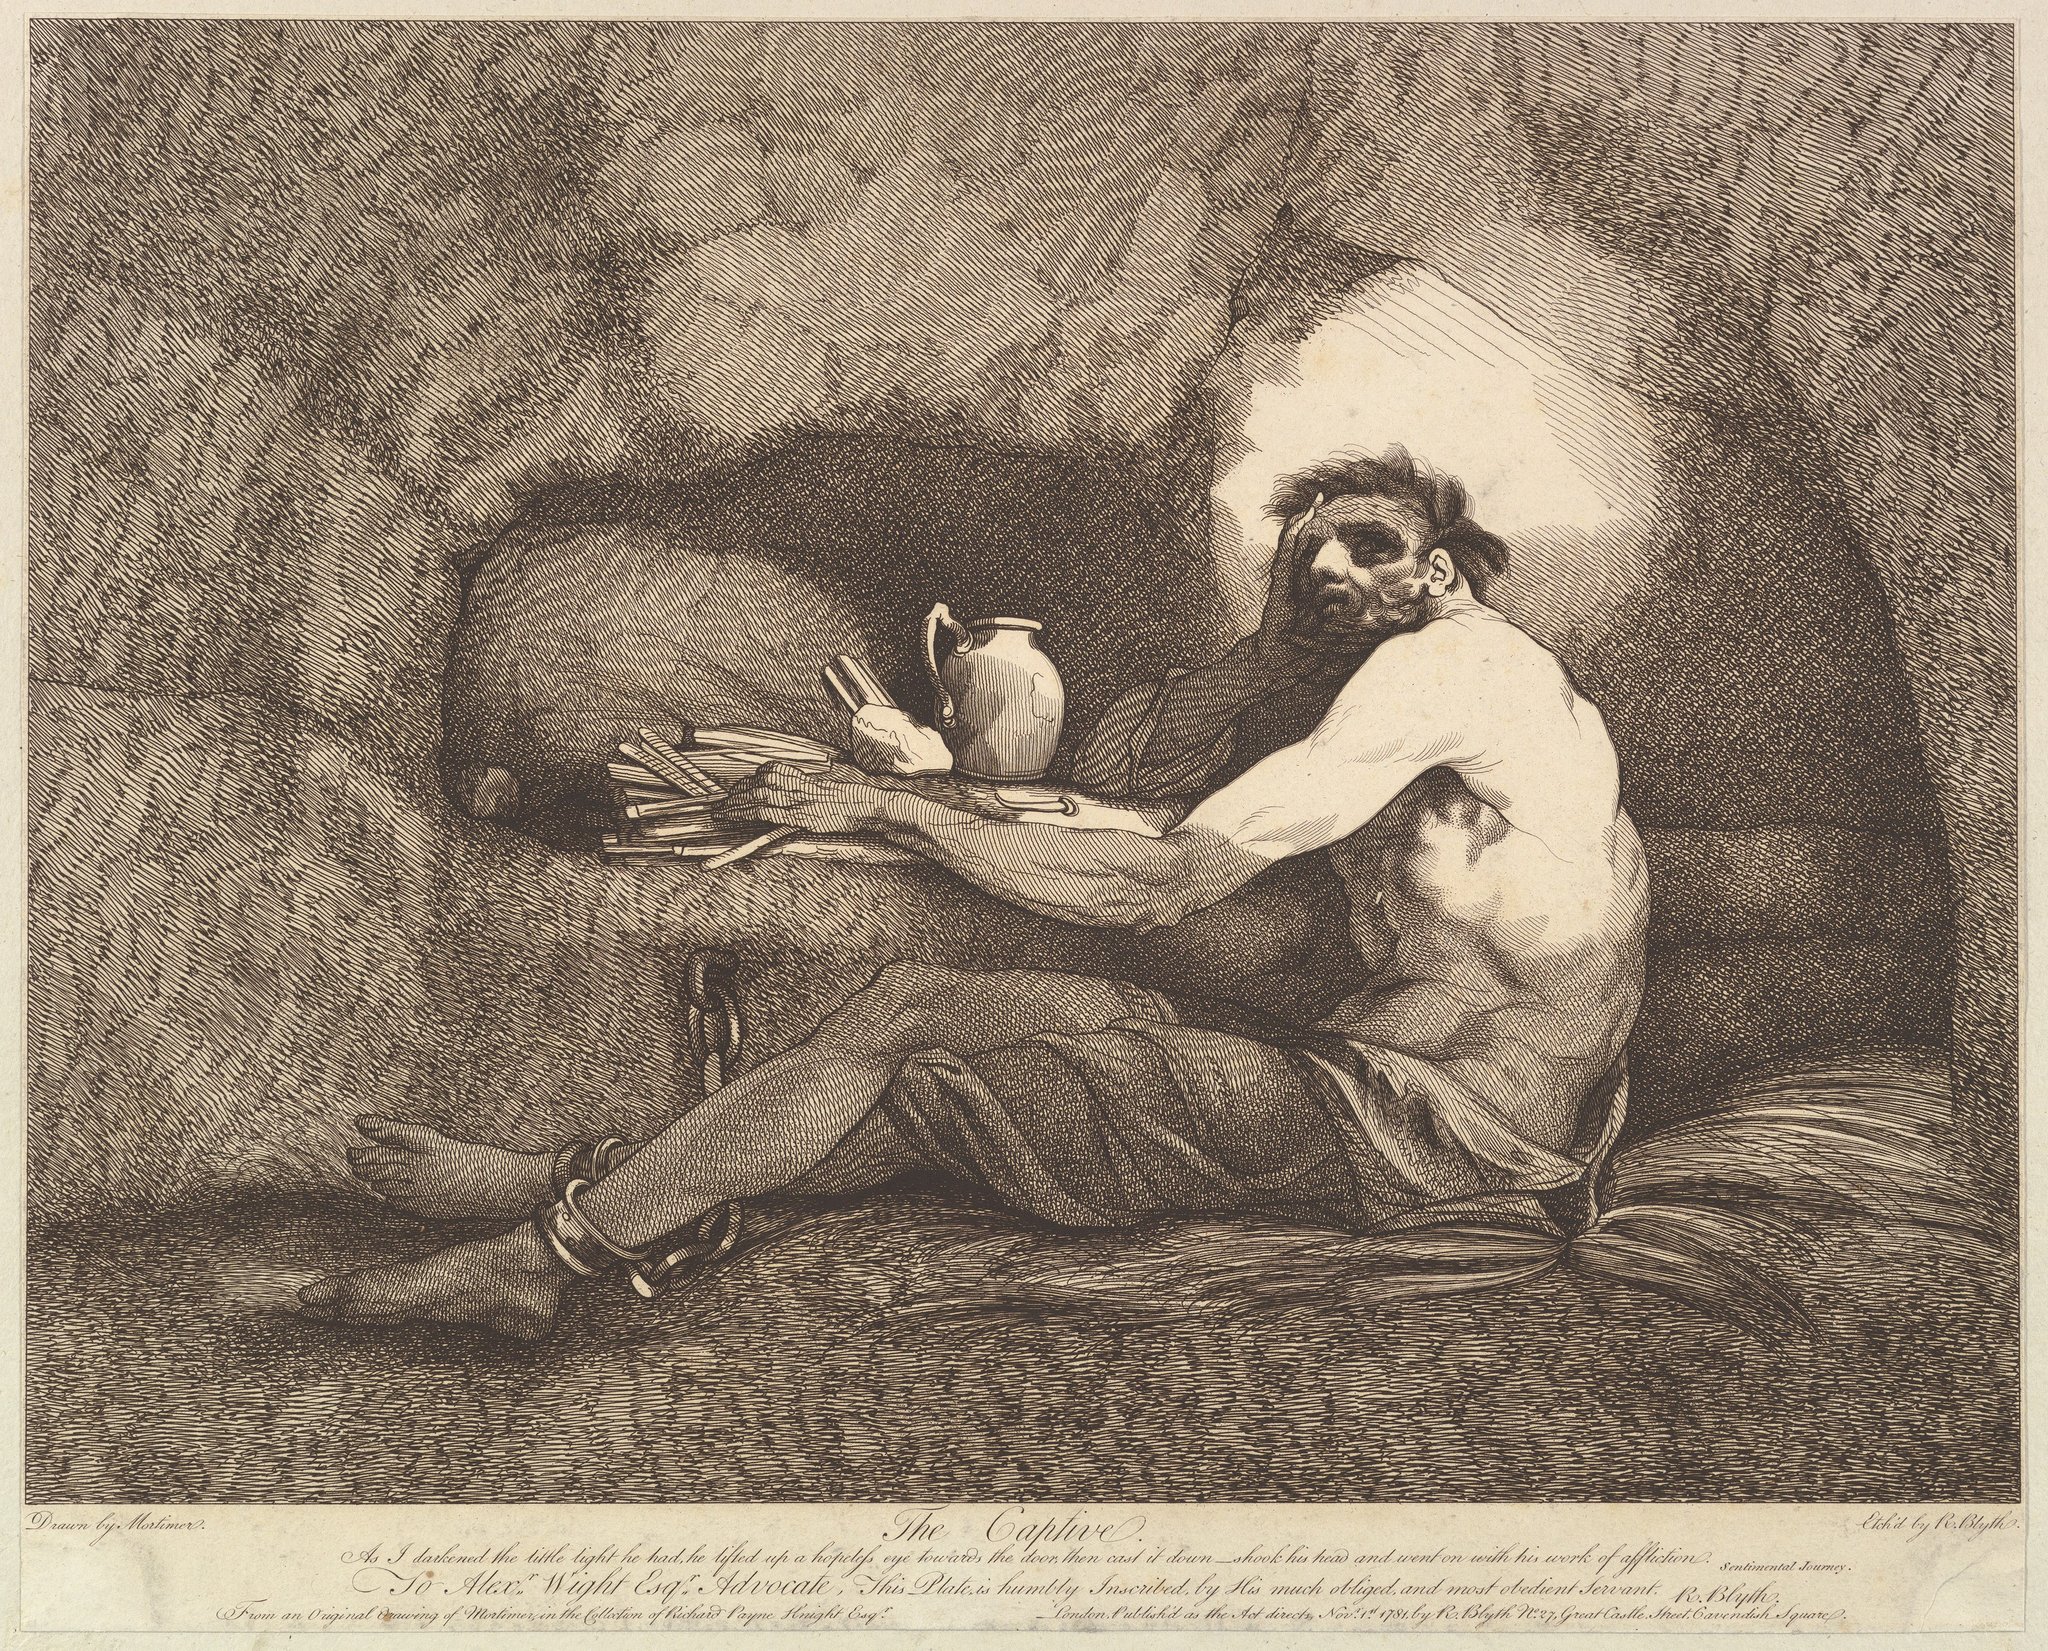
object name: print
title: The Captive, from "Sterne's Sentimental Journey"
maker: robert blyth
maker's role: artist and publisher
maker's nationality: british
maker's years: 1750-1784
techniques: etching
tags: prisoners,men